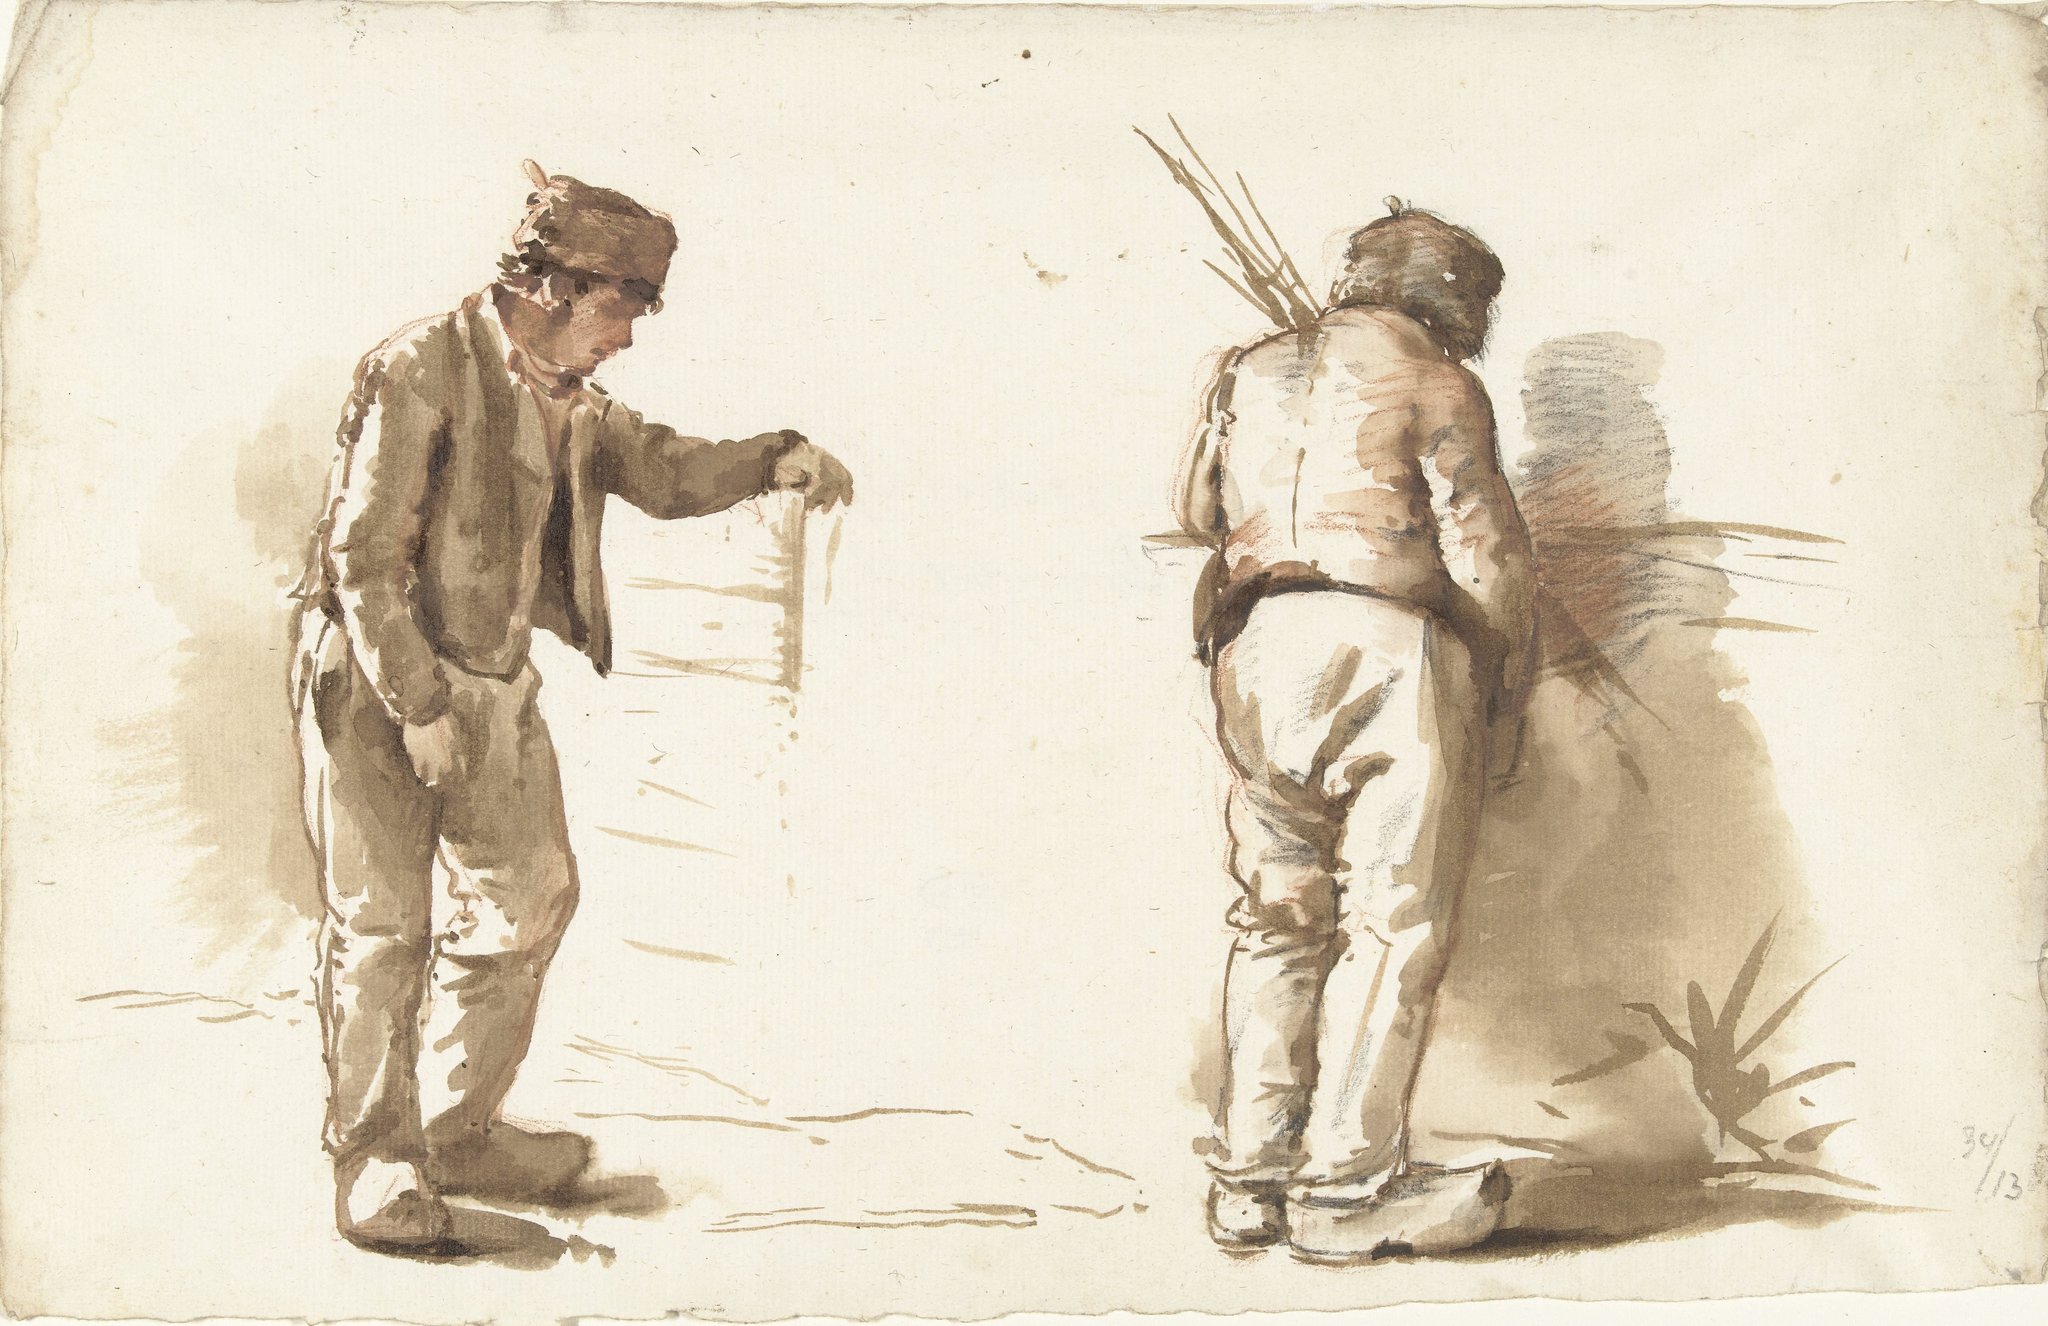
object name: drawing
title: Twee studies van een staande man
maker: abraham johannes ruytenschildt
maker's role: draughtsman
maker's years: 1778-1841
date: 1815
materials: chalk, paper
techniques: brush